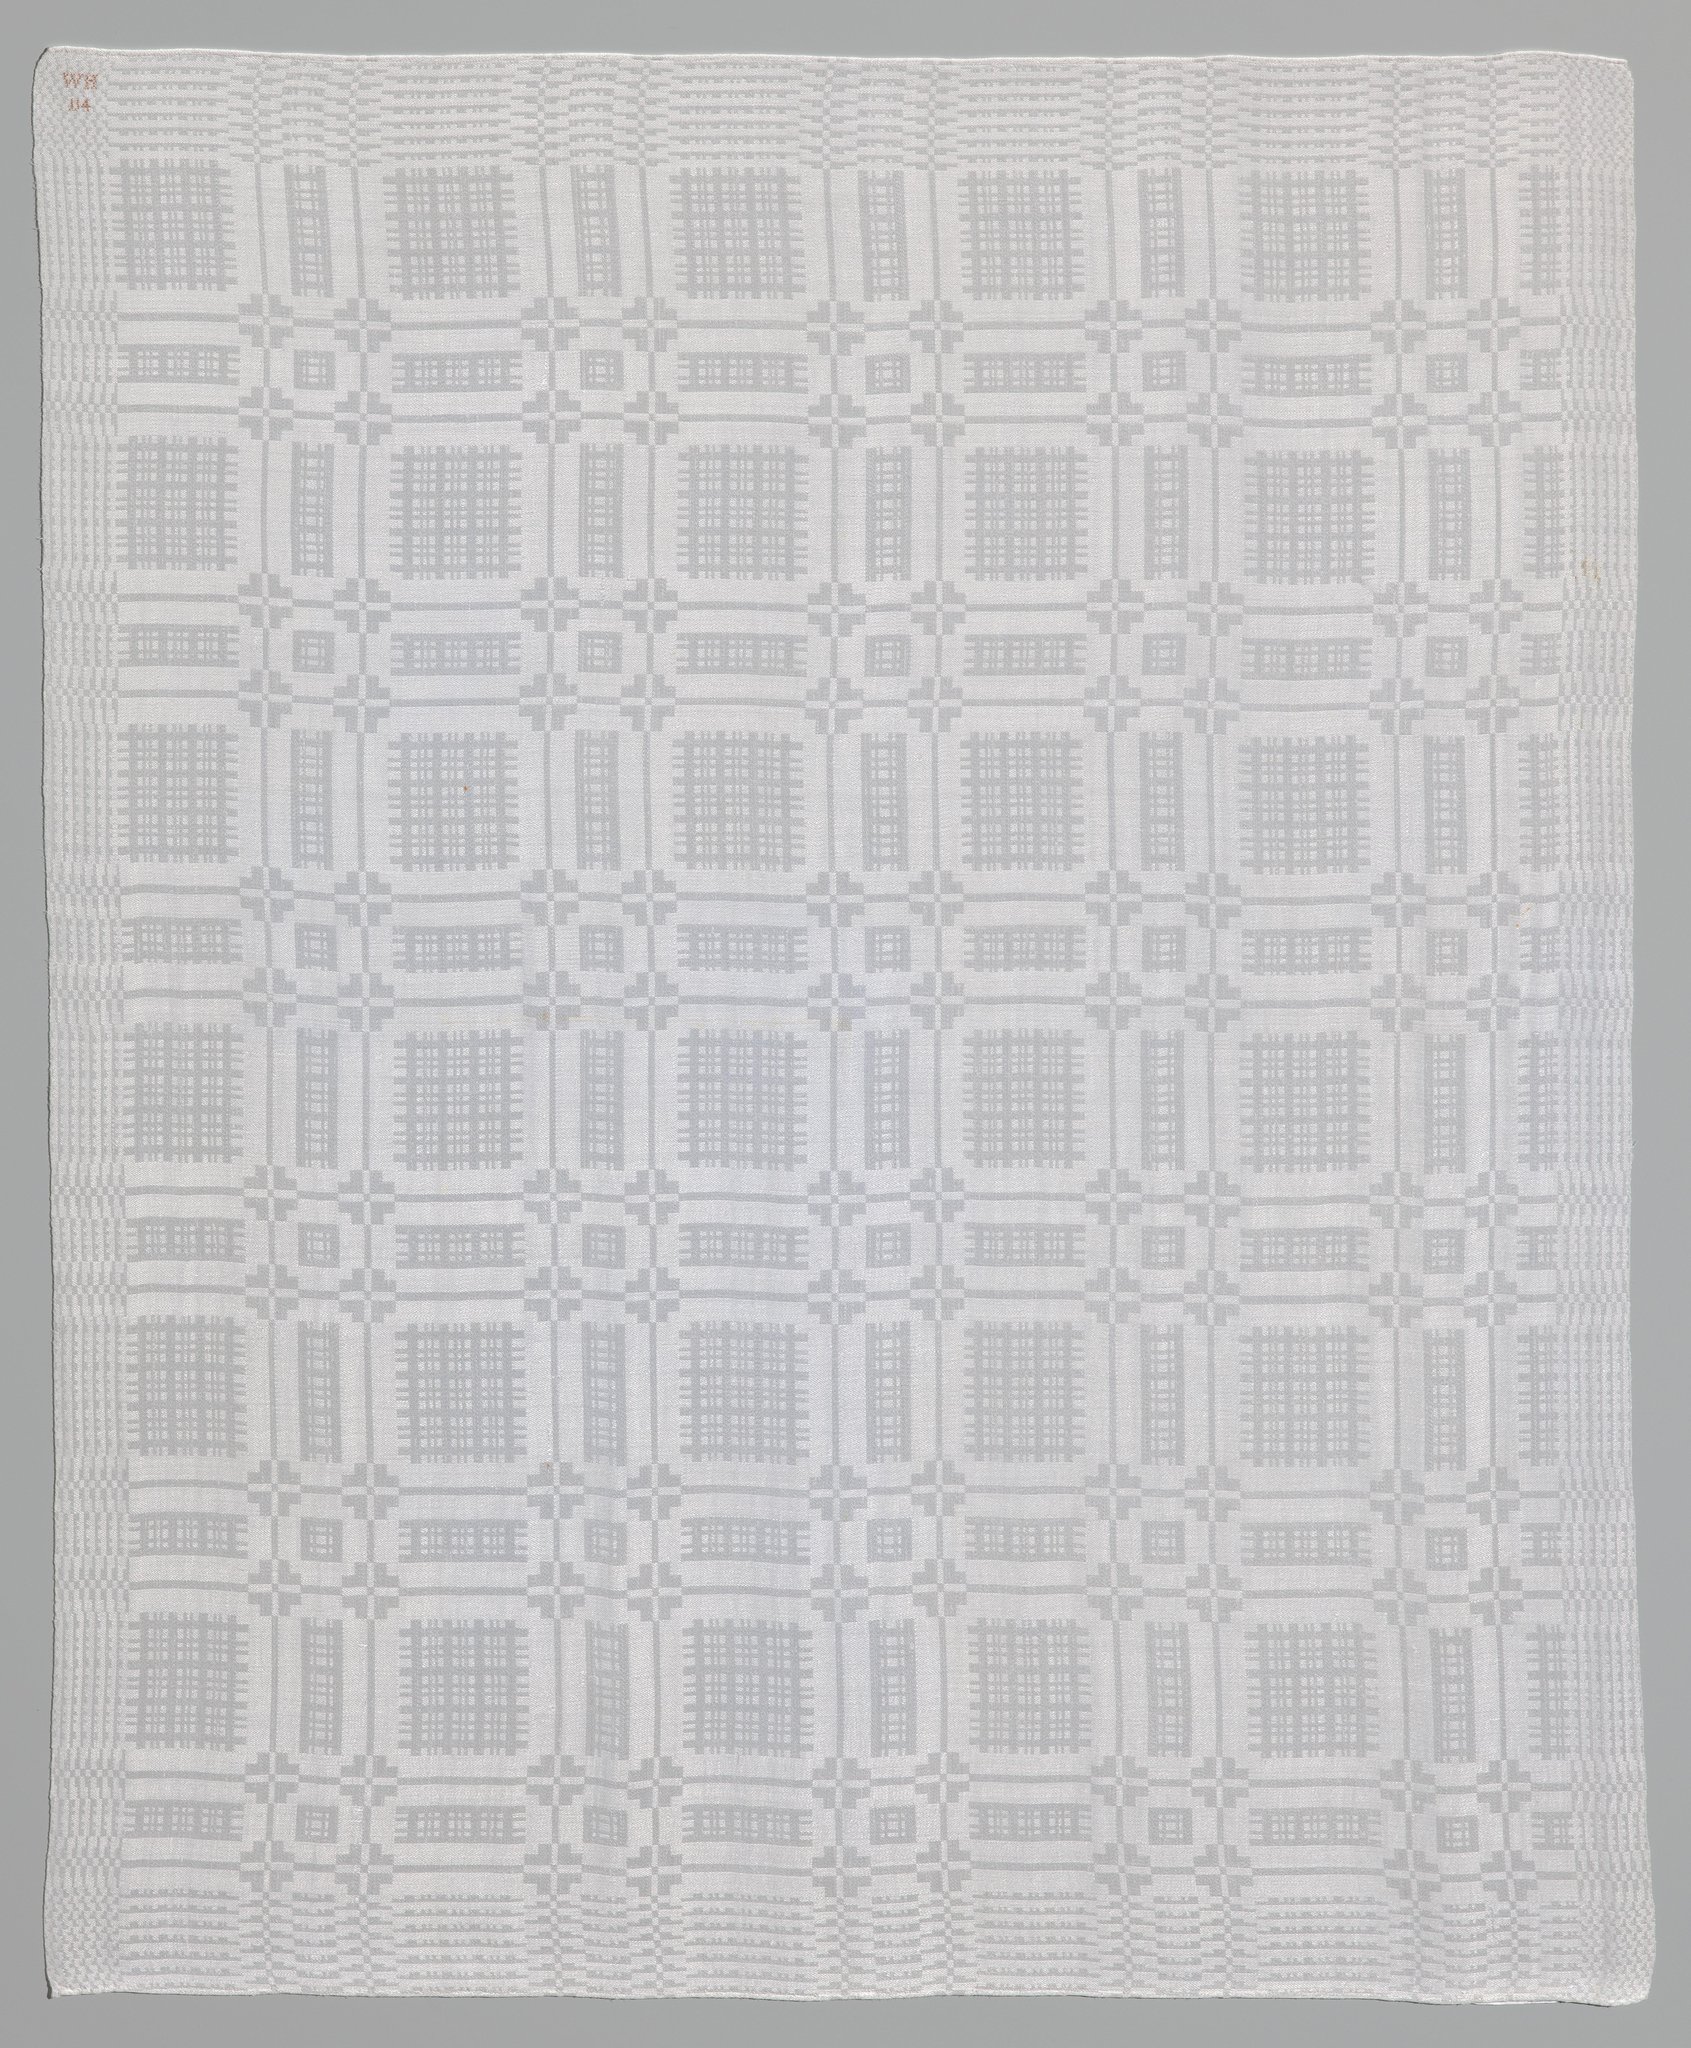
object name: napkin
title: Pellen. Merk: WH114WH 2oonl.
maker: Anonymous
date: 1800-1899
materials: linen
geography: netherlands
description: Servet van wit linnen met een pellen patroon, merk WH 114 WH 2oonl.